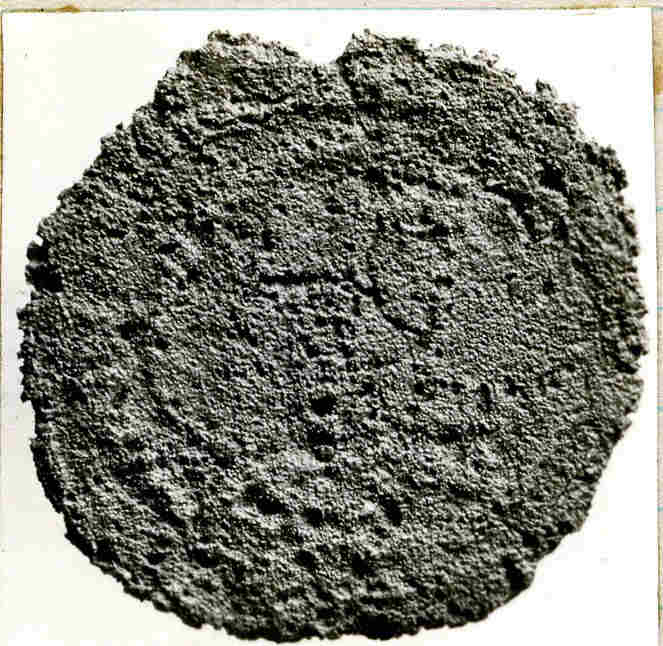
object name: coin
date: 701-900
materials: copper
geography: iran